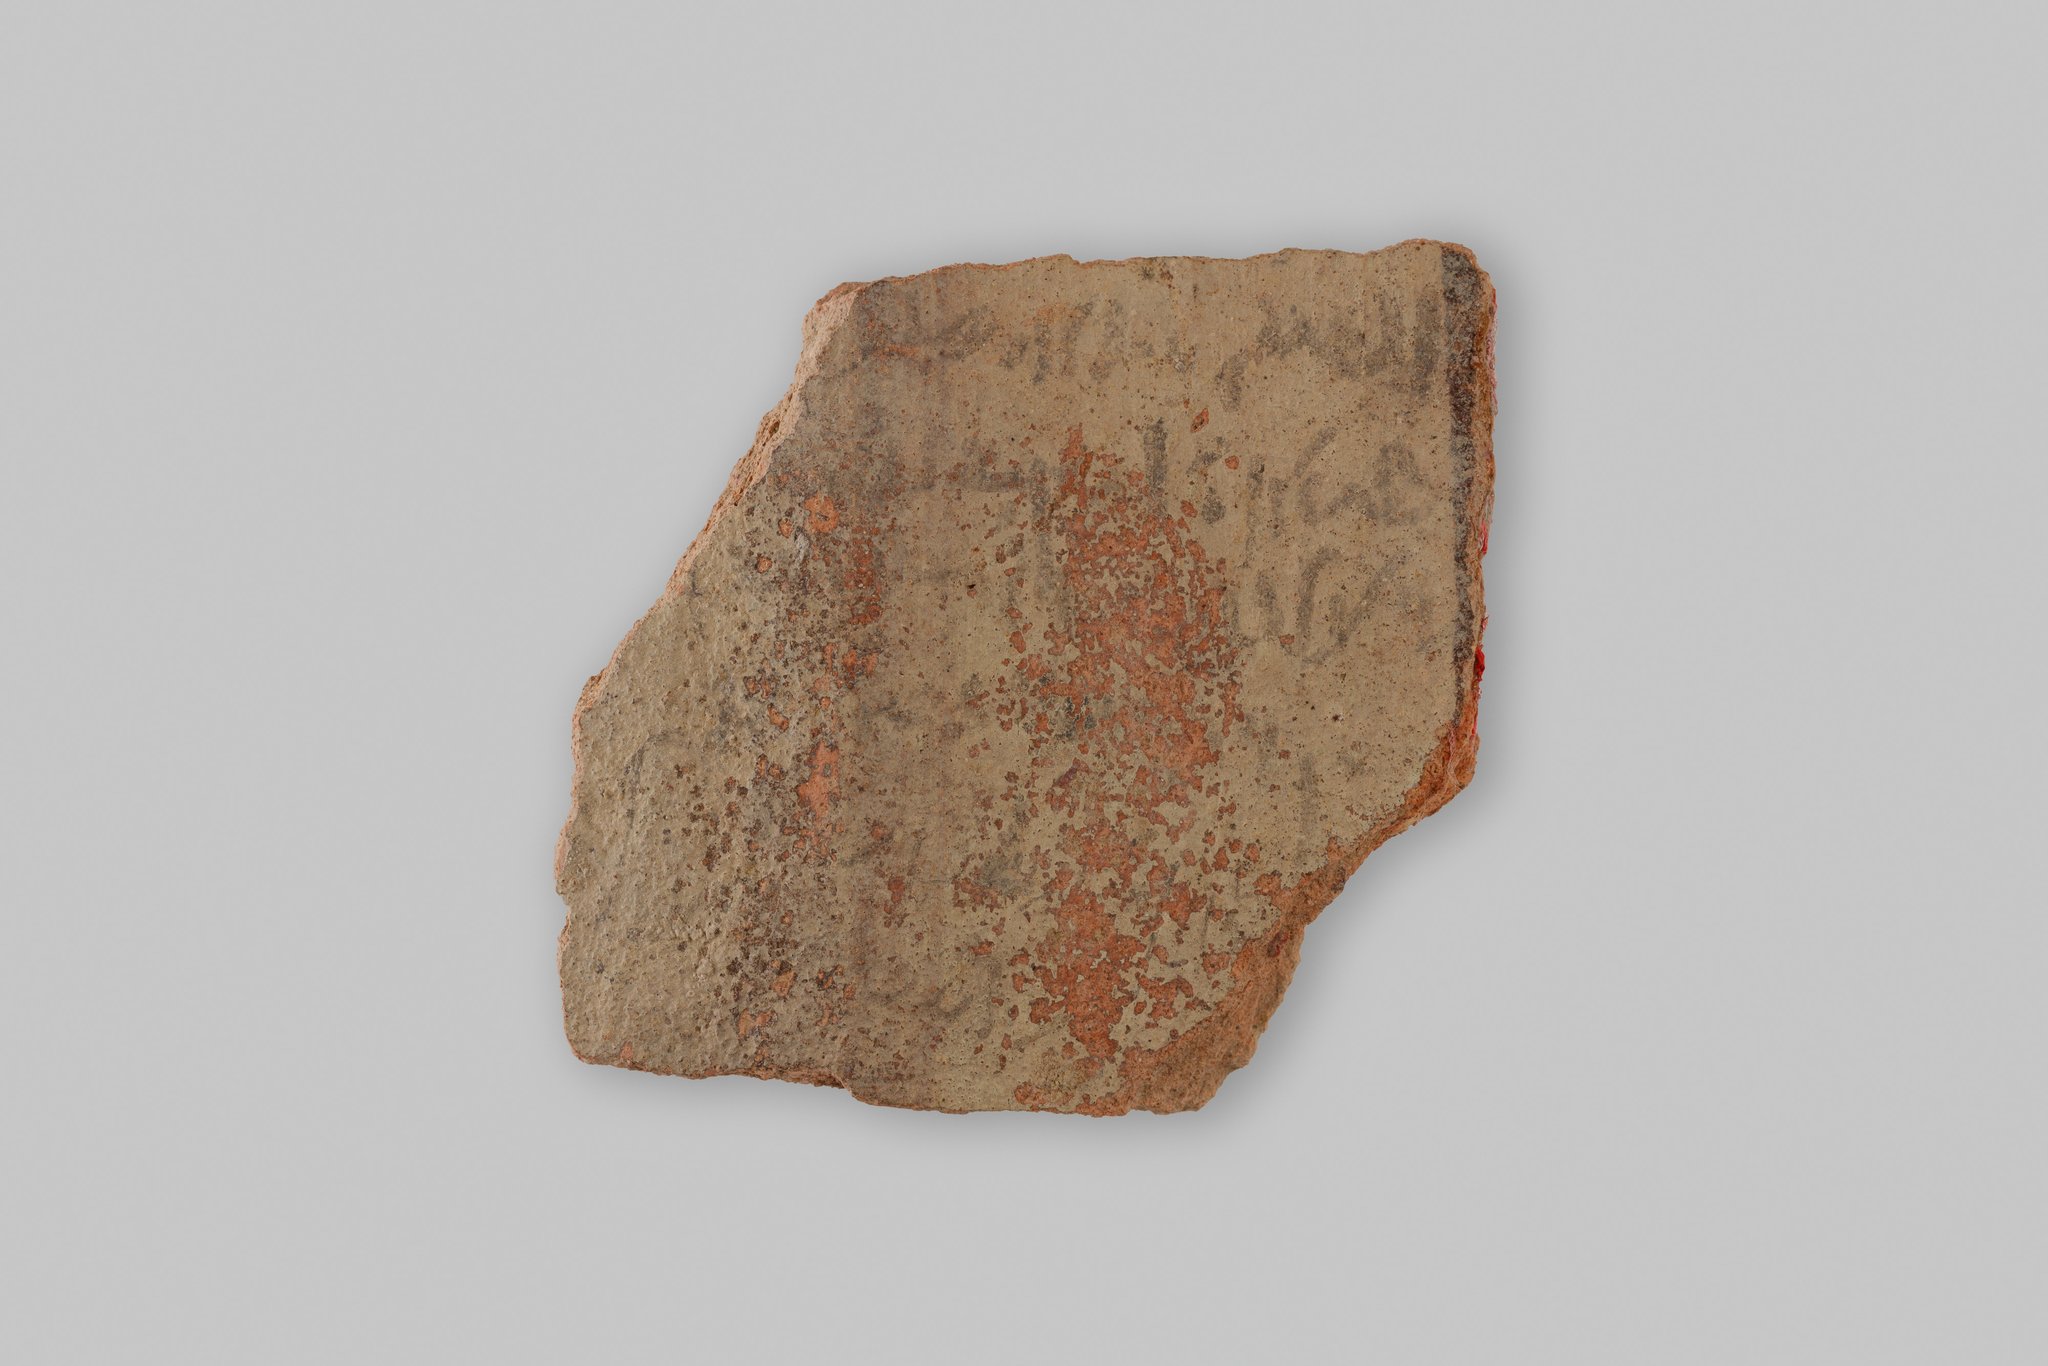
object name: ostracon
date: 400-30 BCE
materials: ink, pottery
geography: egypt